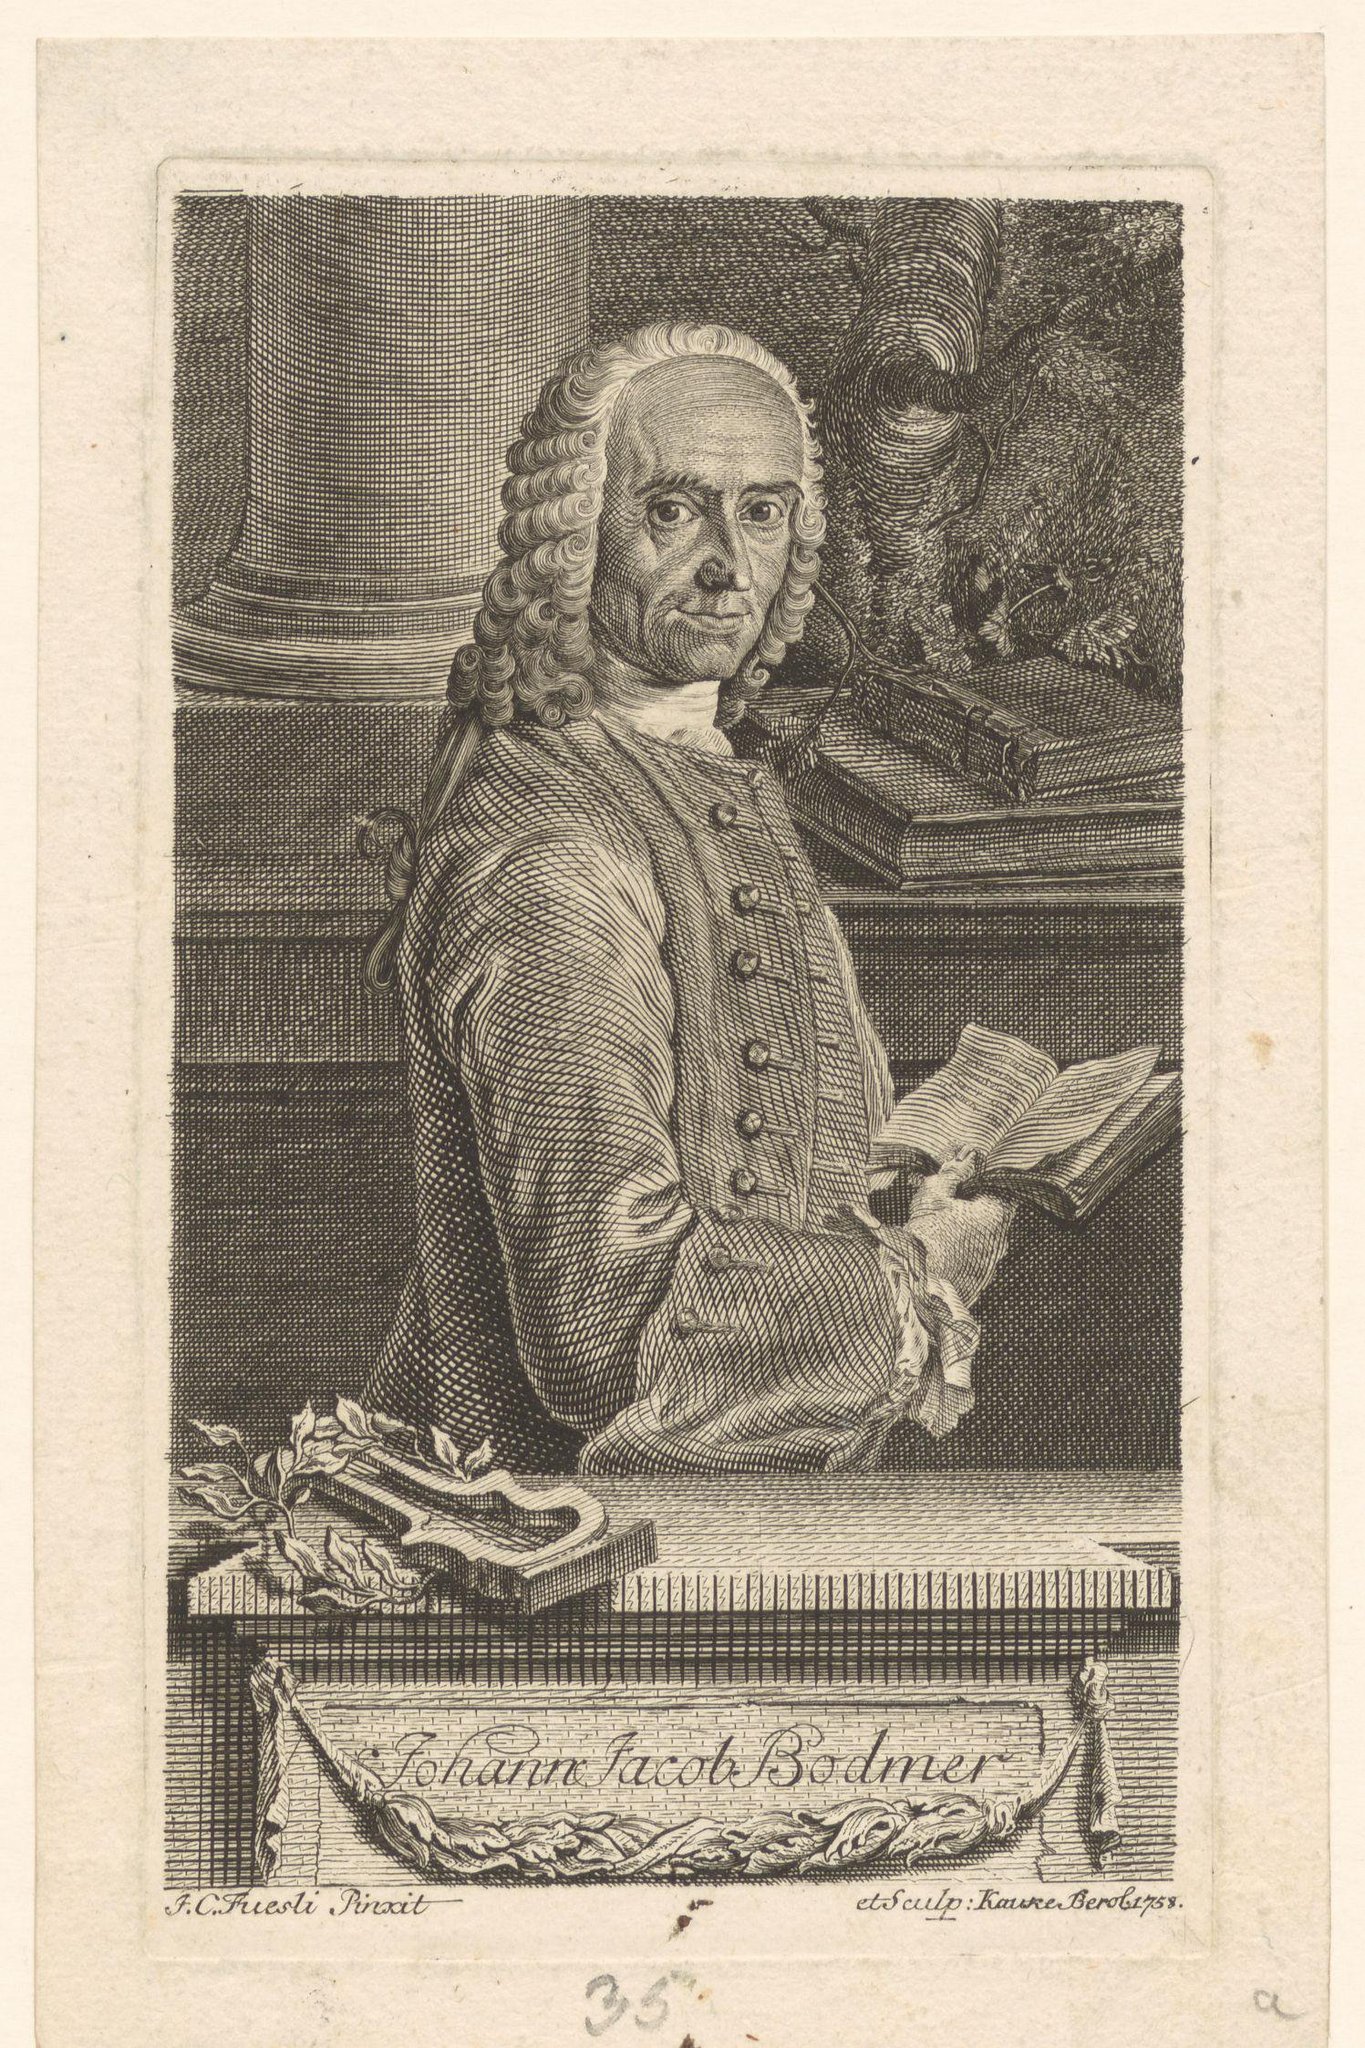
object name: print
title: Portret van Johann Jakob Bodmer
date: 1758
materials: paper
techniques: engraving, etching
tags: history and archaeology (+ portrait of scholar, scientist), scholar, philosopher, historical persons, writer, poet, author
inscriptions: collector's mark: Lugt 2228, collector's mark: Lugt 1388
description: Portret gebaseerd op schilderij door Fuesli, dat zich in de Zentralbibliothek Zürich bevindt onder inv.nr. 500000004.